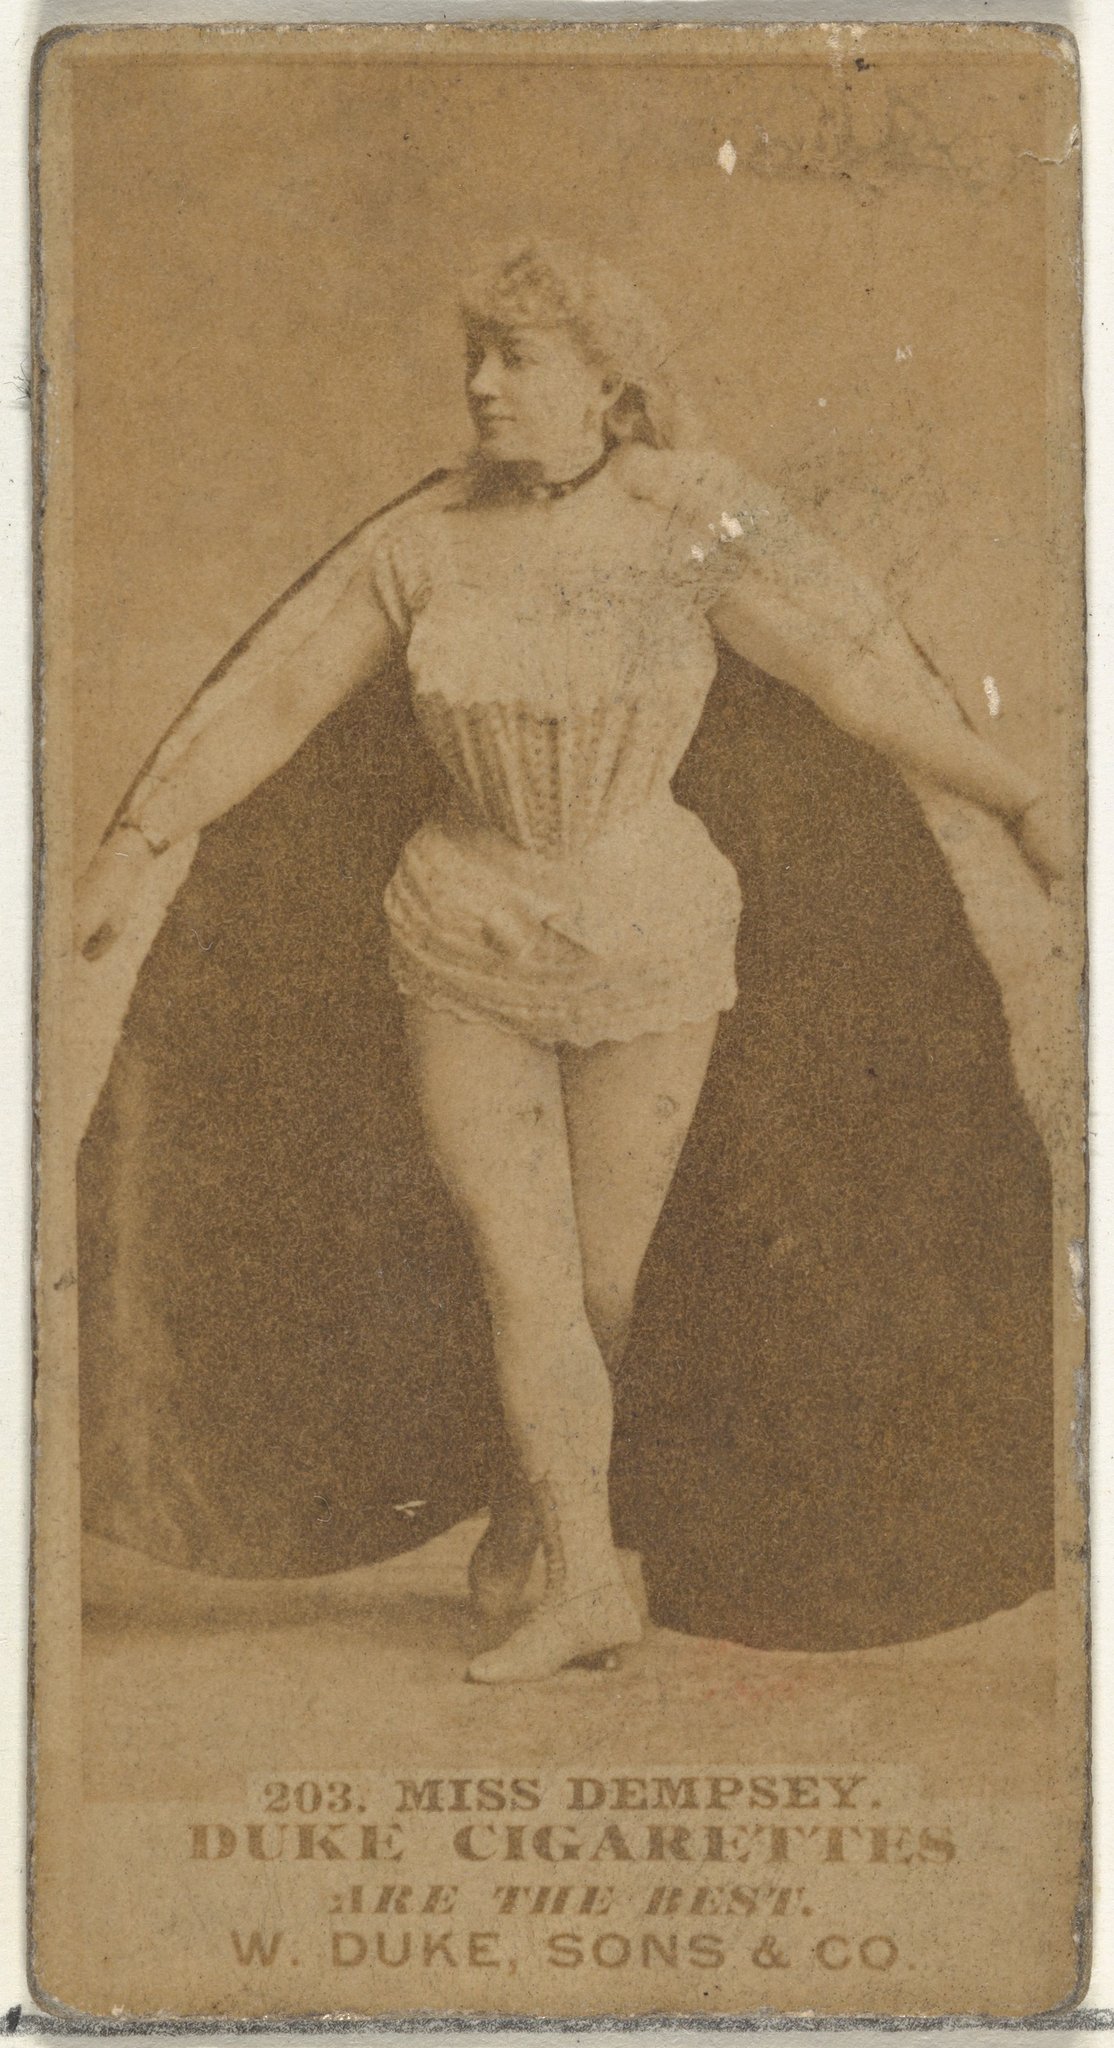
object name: photograph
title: Card Number 203, Miss Dempsey, from the Actors and Actresses series (N145-7) issued by Duke Sons & Co. to promote Duke Cigarettes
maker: w. duke, sons & co.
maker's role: publisher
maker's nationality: american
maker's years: 1870-1920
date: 1880-1889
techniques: albumen silver print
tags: portraits,women,actresses